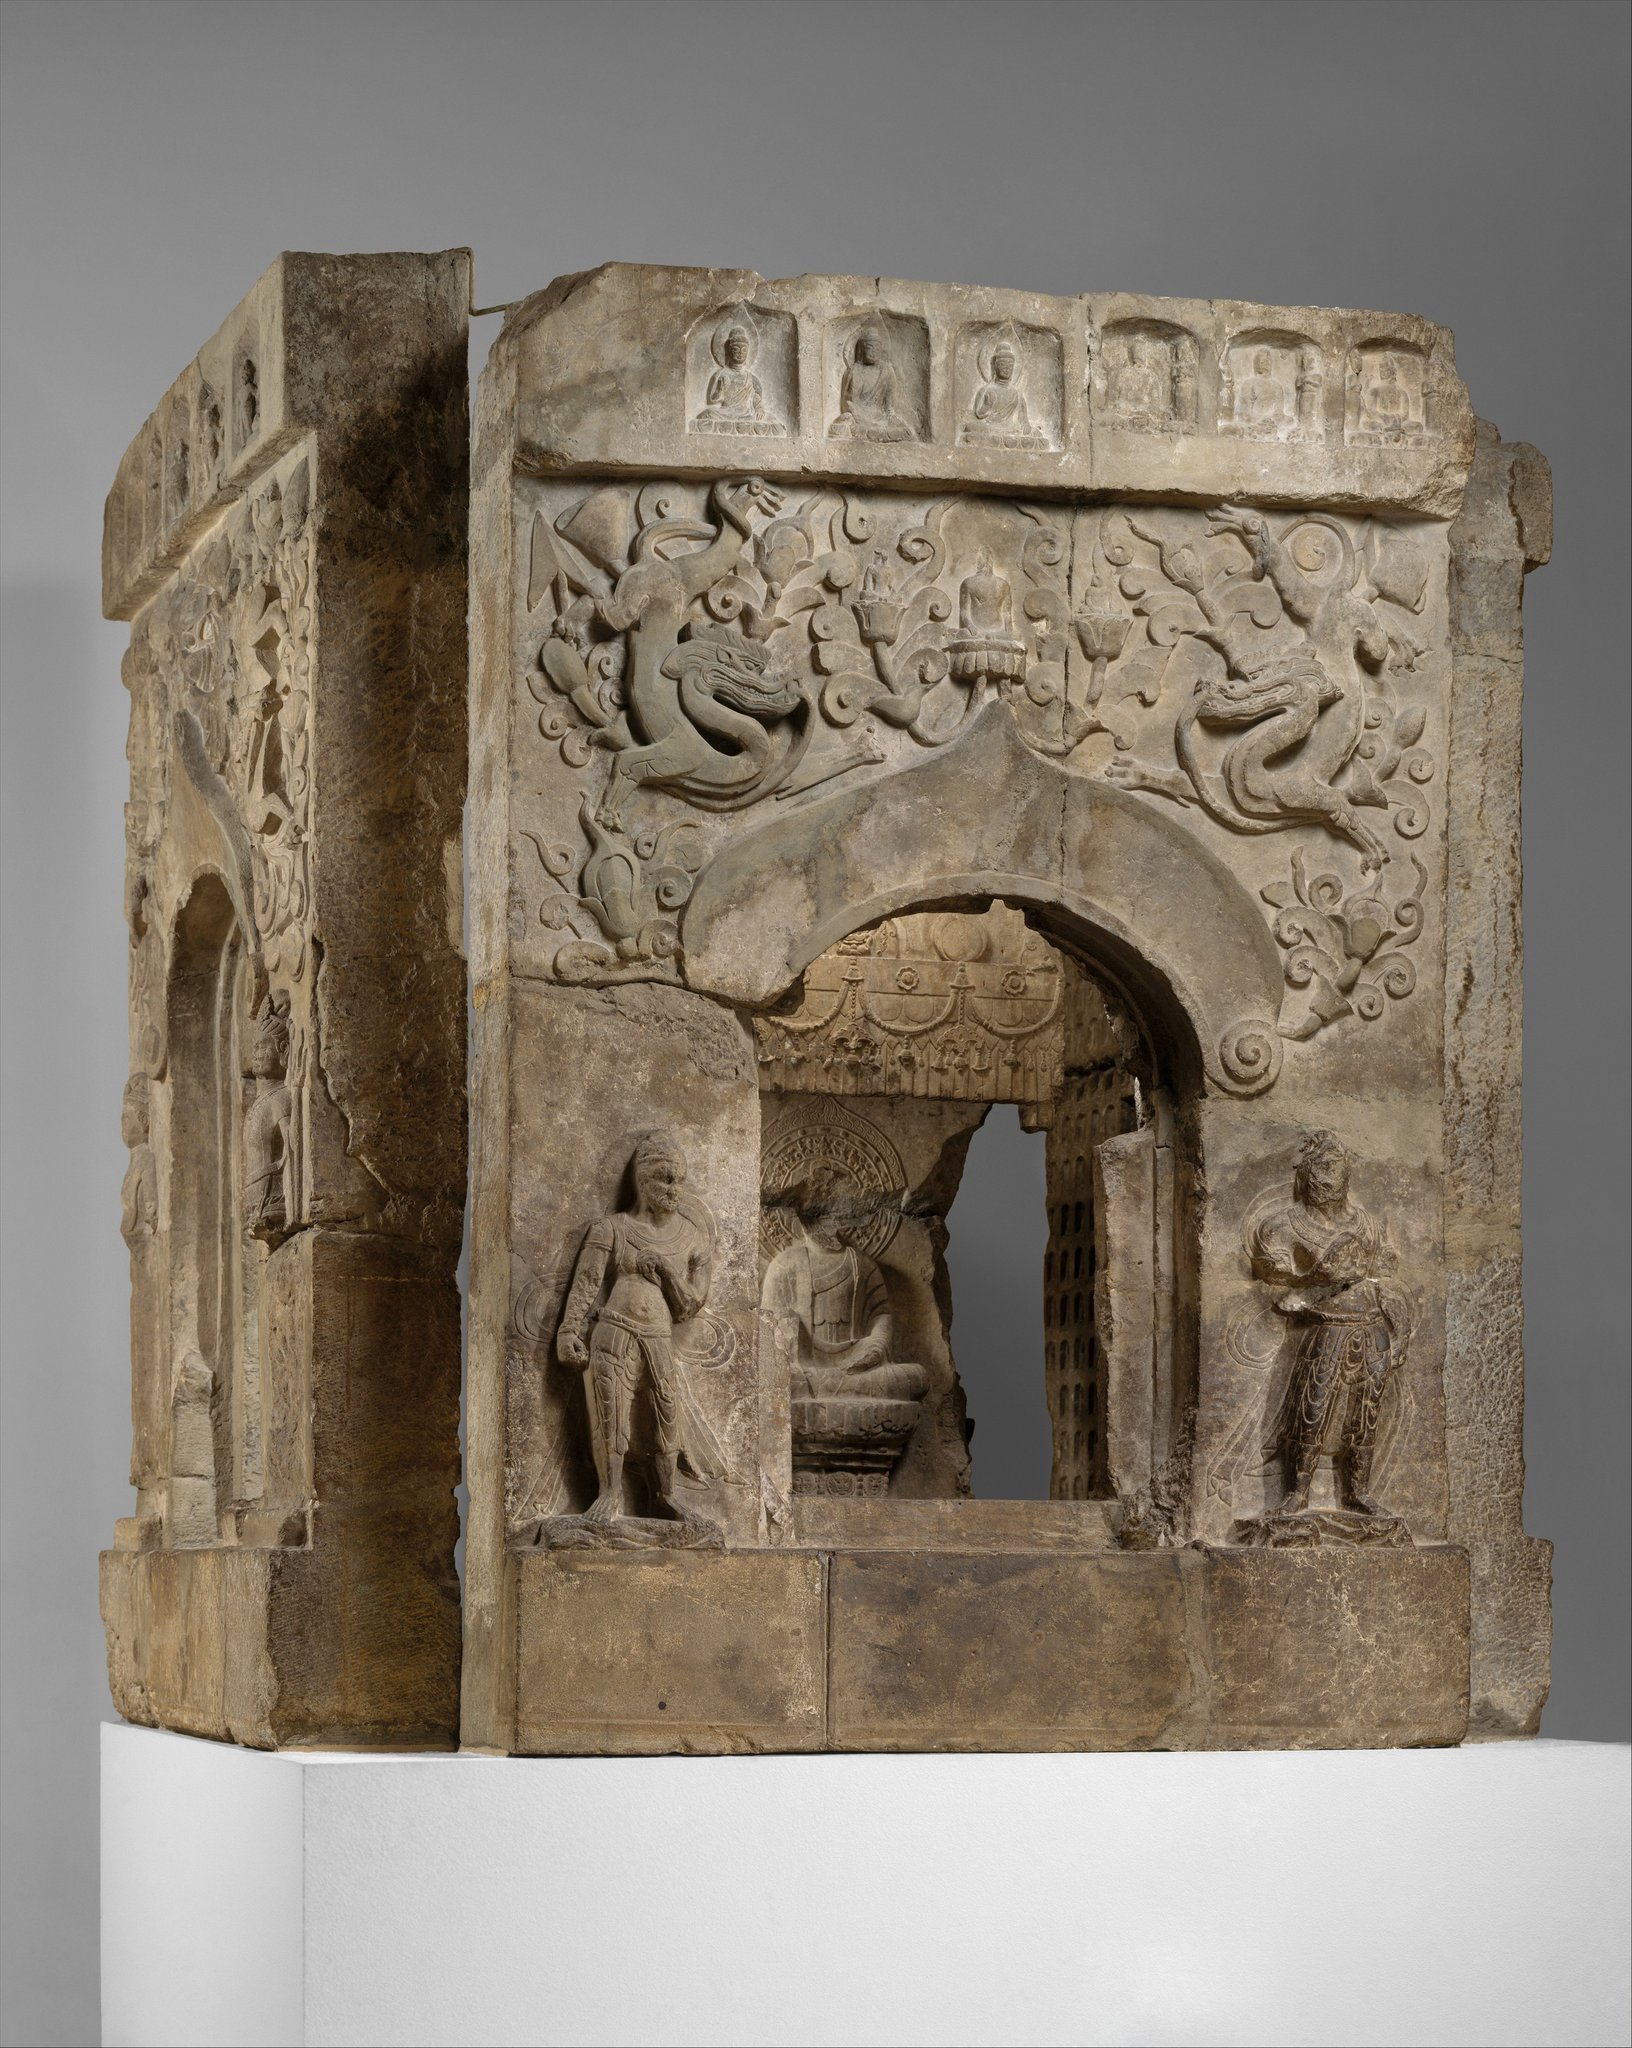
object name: pagoda base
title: Pagoda base with four Buddhas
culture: chinese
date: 560-575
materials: limestone, pigment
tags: dragons,buddha